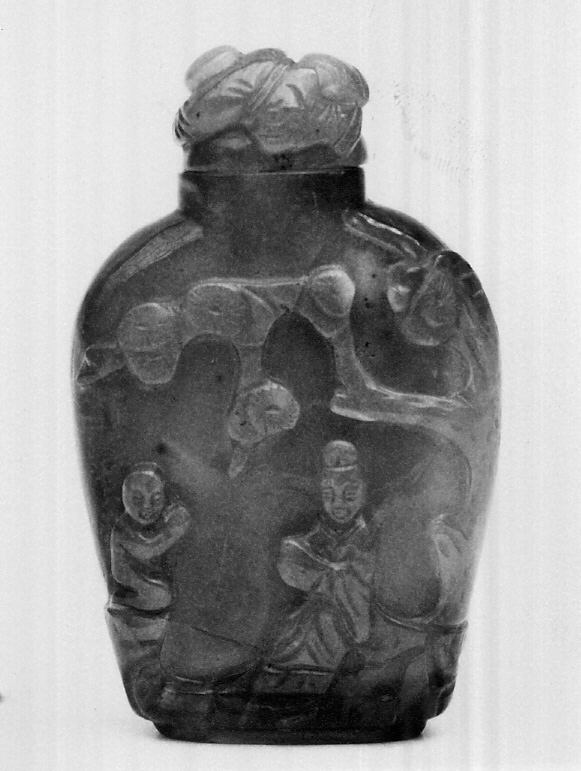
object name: snuff bottle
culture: chinese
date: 1701-1800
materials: gemstone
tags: human figures